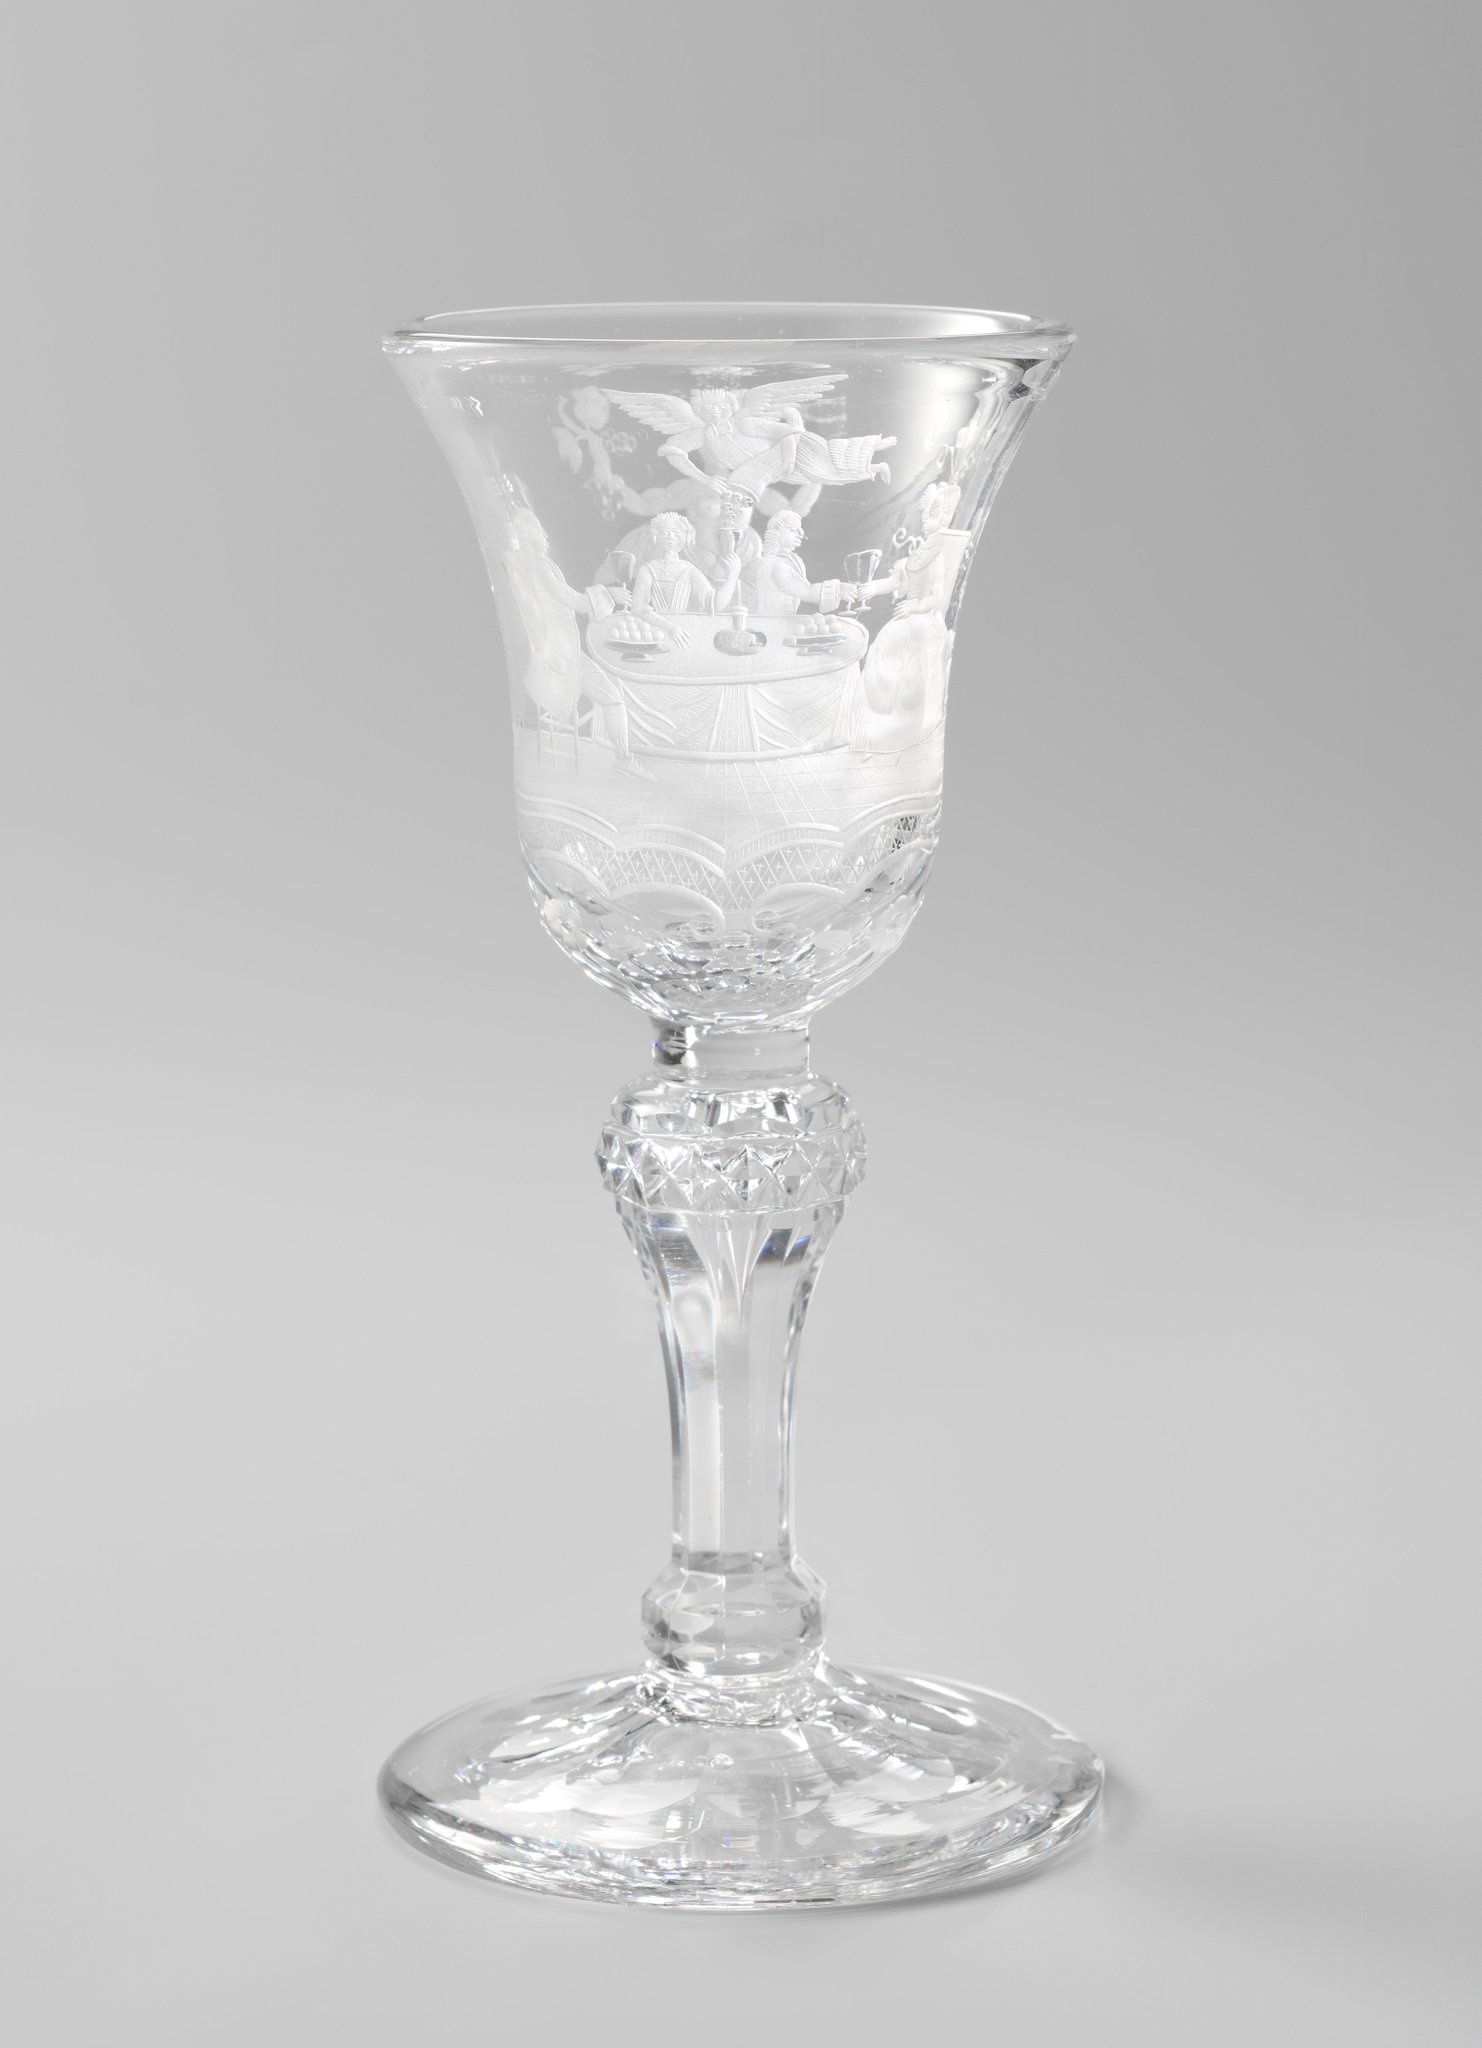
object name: goblet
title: Wine glass with a company drinking and a bacchante on a barrel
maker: Anonymous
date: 1750-1775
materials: glass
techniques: glassblowing, grinding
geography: germany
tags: celebration meal, feast, banquet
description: translation of inscription: The Good Anniversary